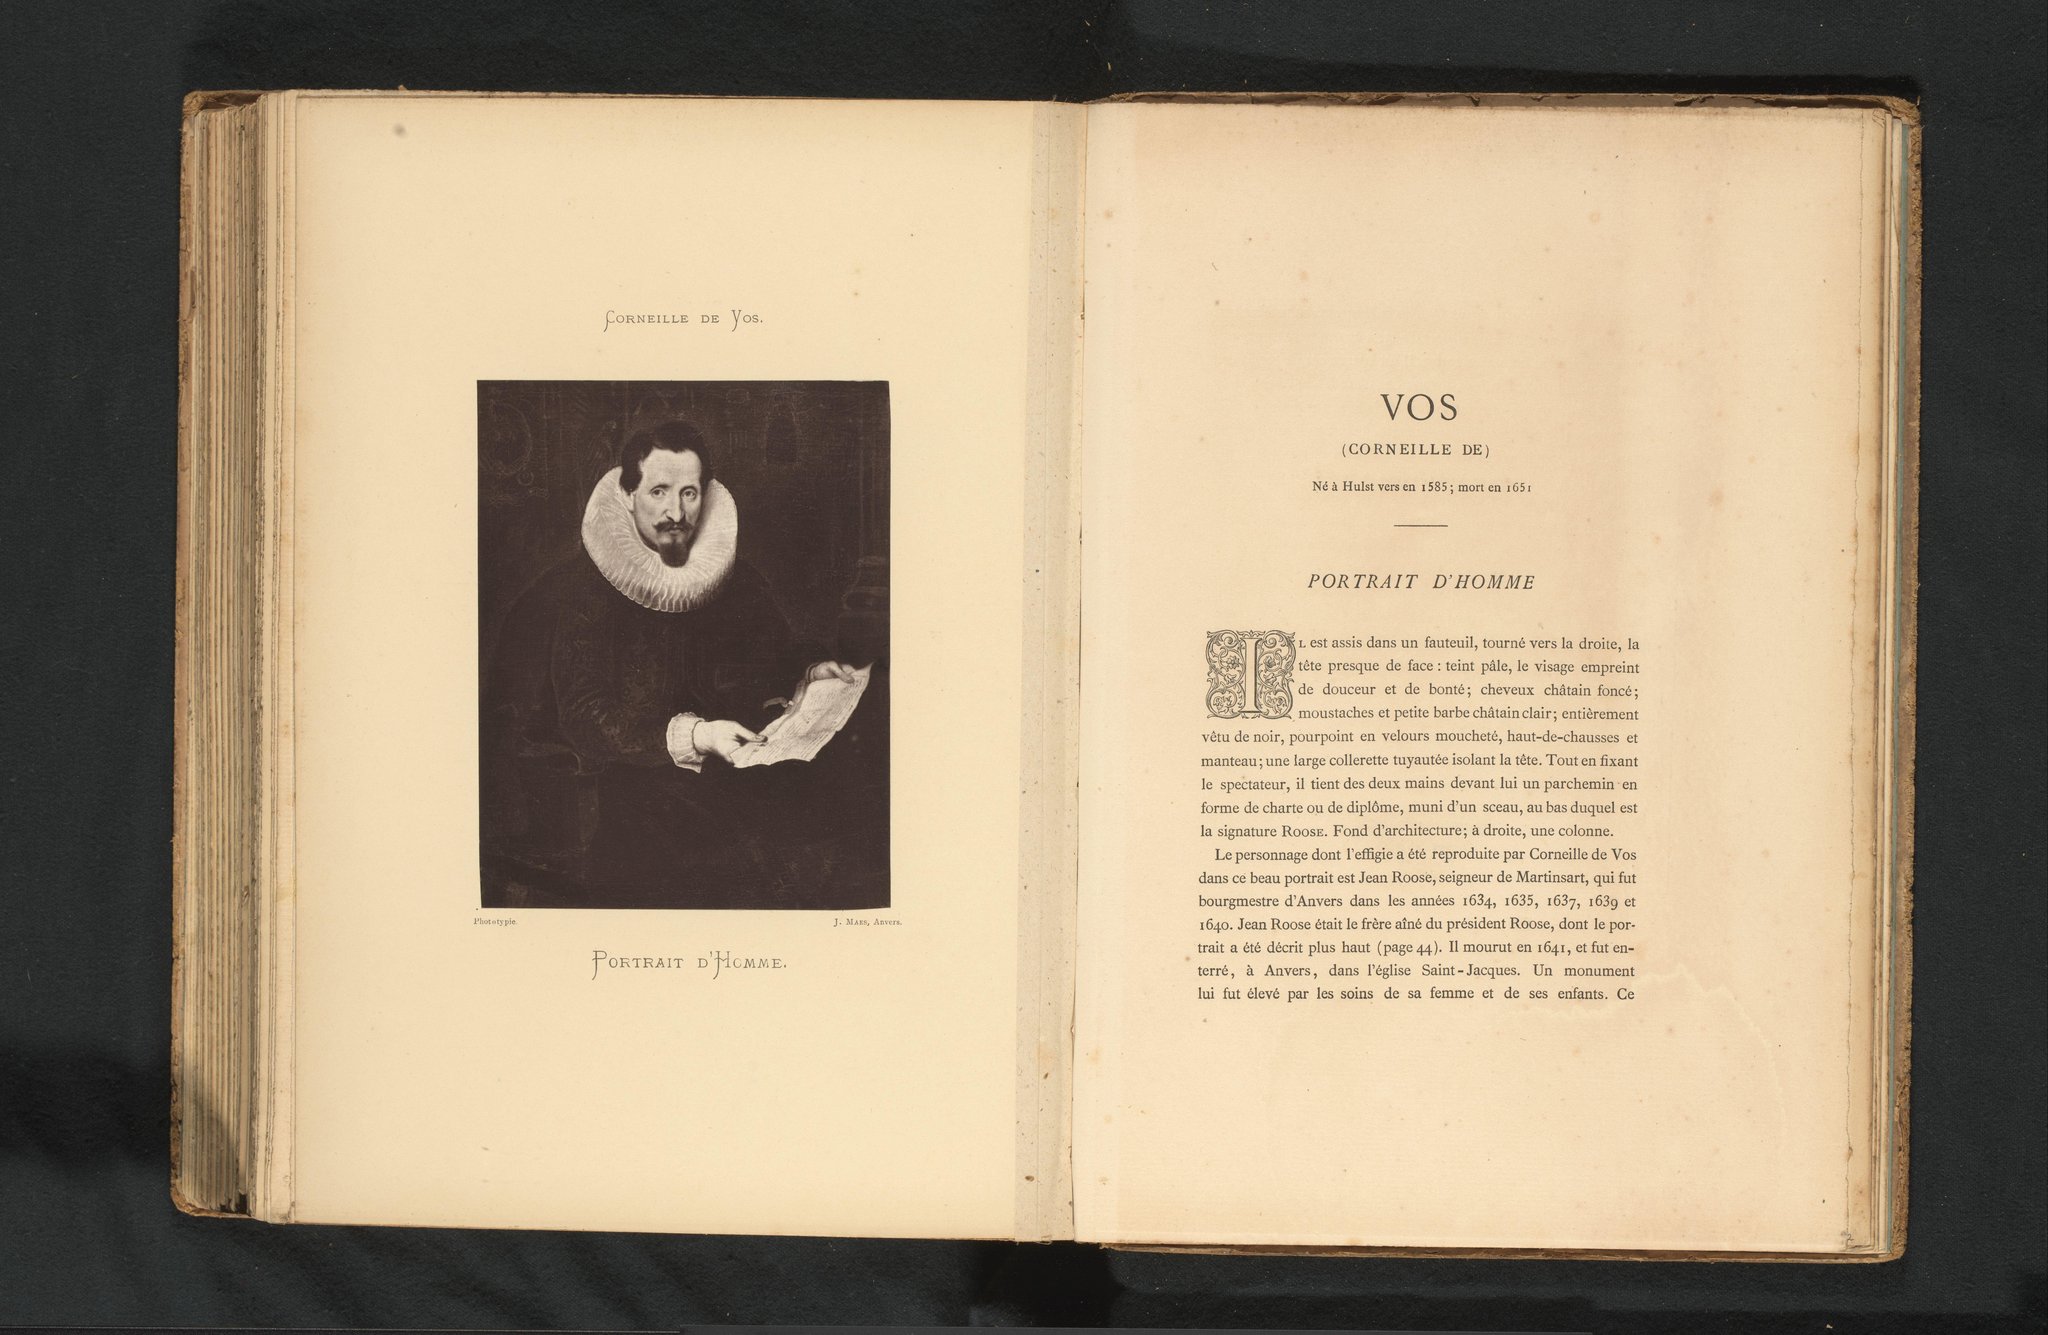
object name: page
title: Reproductie van een geschilderd portret van Jan Roose door Cornelis de Vos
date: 1873-1878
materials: paper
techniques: woodburytype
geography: antwerp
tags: mayor, burgomaster, historical persons